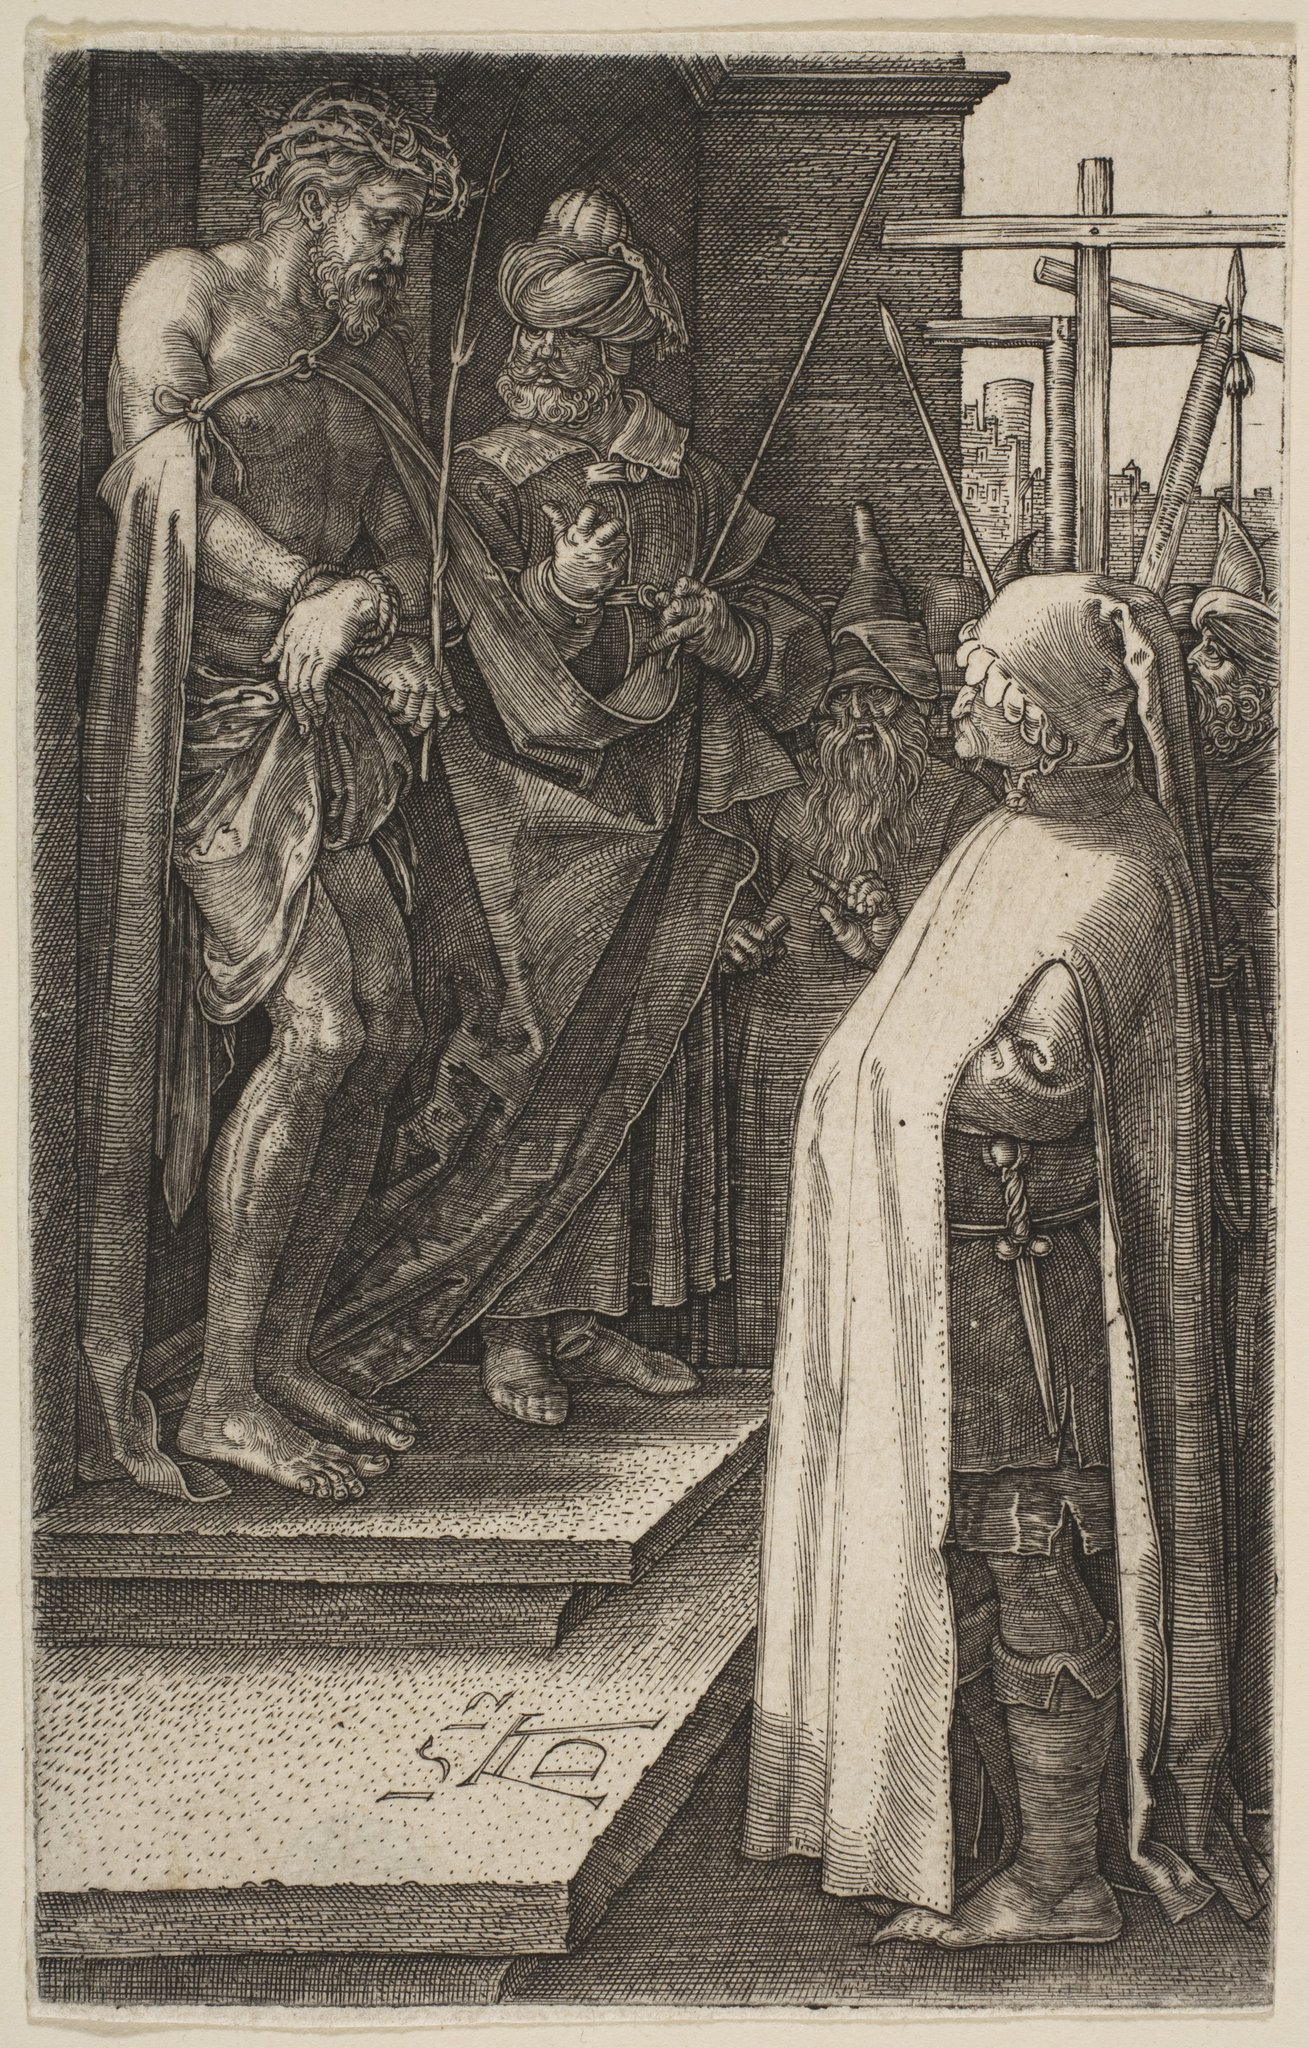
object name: print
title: Ecce Homo, from "The Passion"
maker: albrecht dürer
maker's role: artist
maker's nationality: german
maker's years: 1471-1528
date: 1512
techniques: engraving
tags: knives,men,christ,punishment